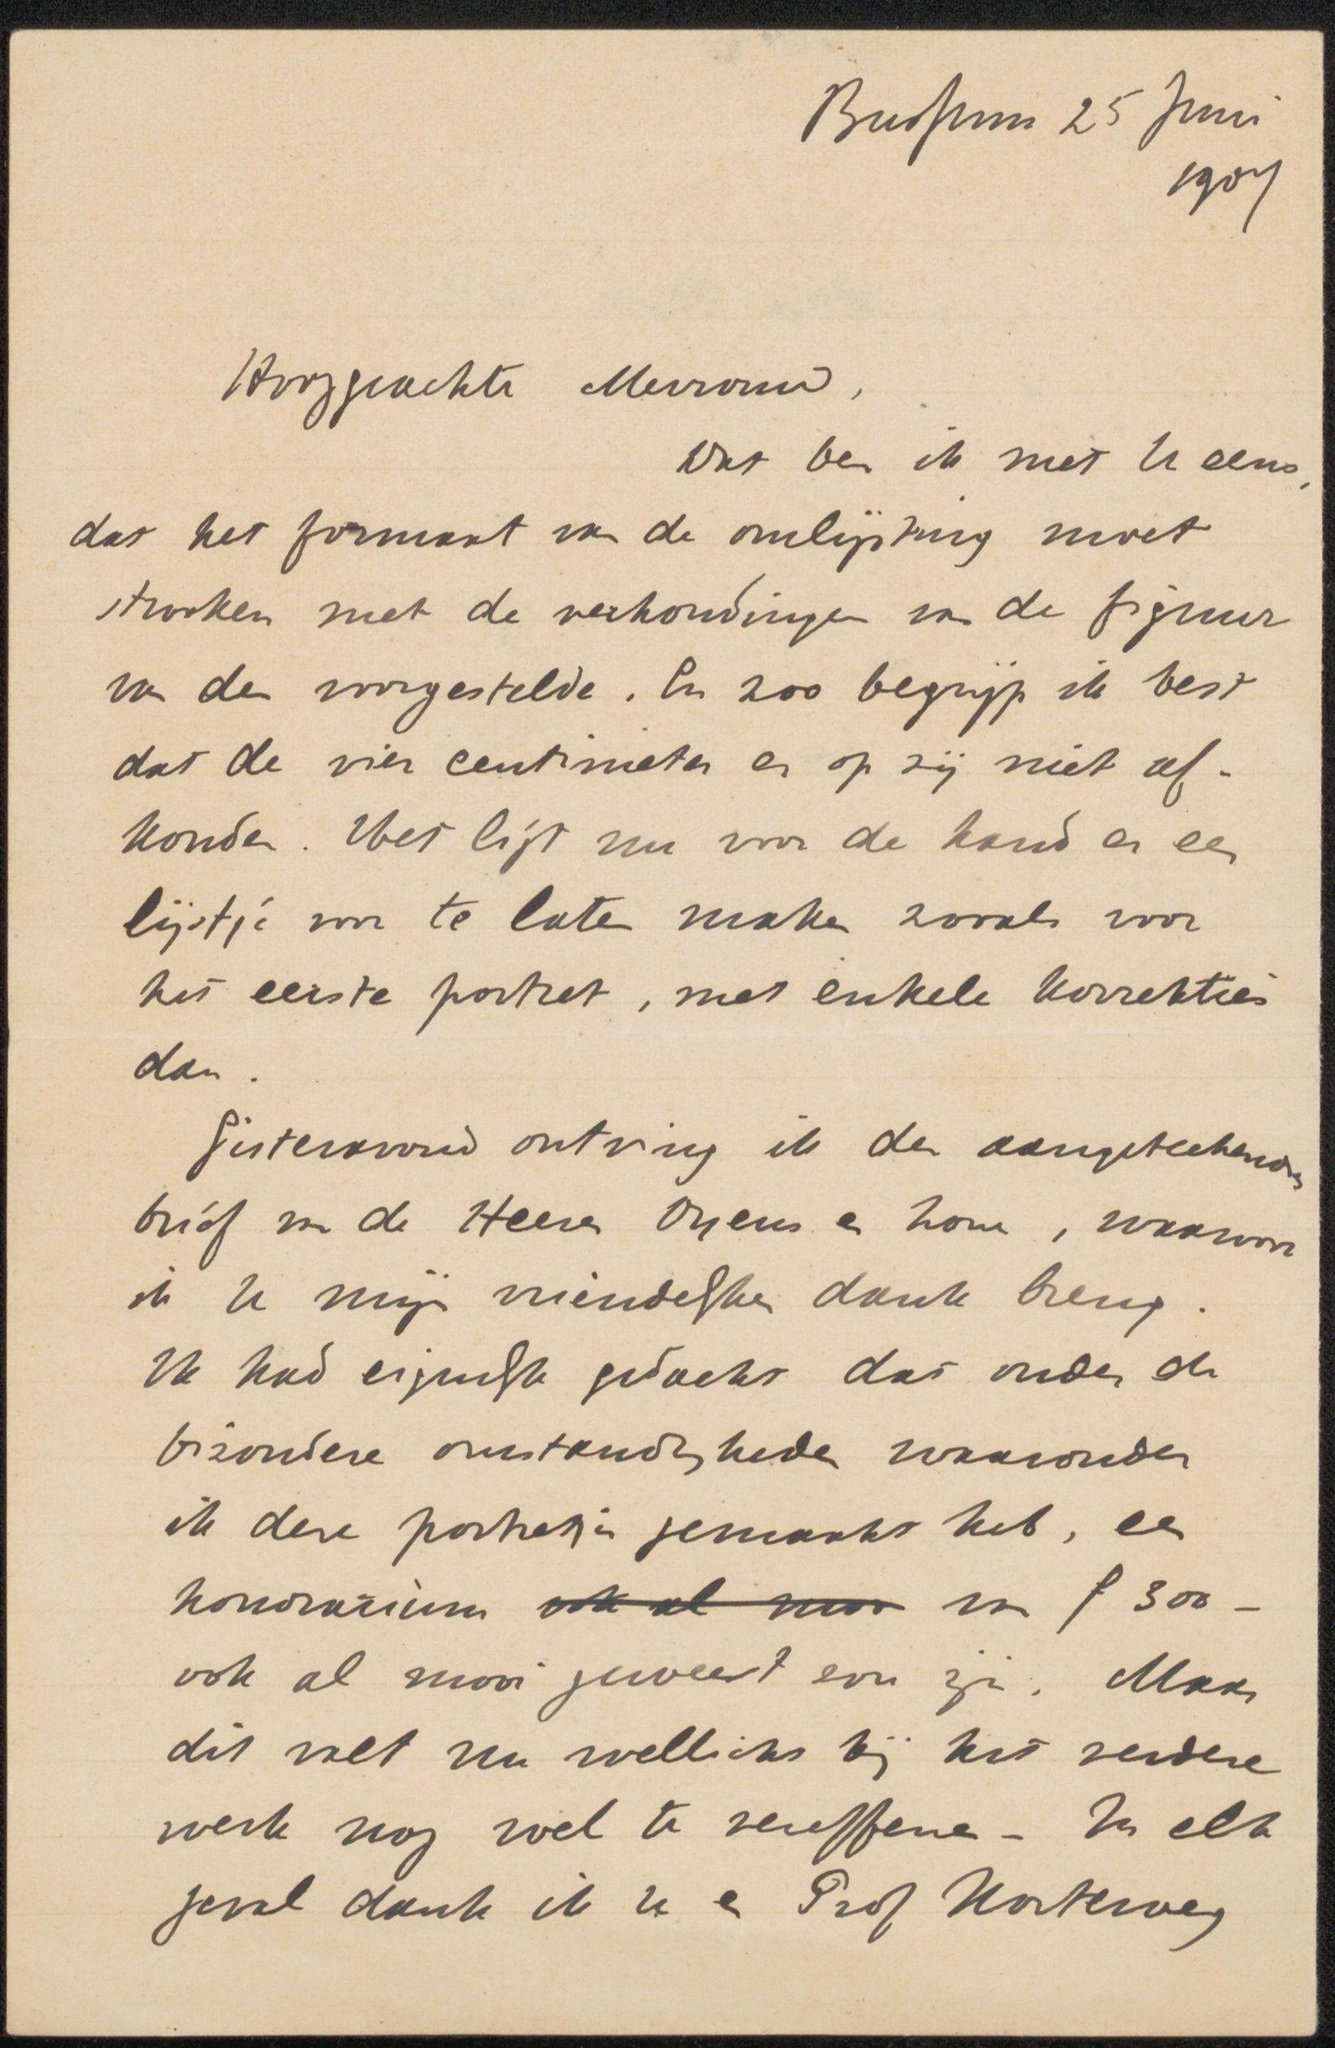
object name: letter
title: Brief aan Wibbina Maria Korteweg-d'Aulnis de Bourrouil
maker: jan veth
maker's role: designer, draughtsman, painter, print maker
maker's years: 1864-1925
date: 1907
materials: ink, paper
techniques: pen, writing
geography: bussum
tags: pieter oyens, brussels, david oyens, wibbina maria barones korteweg-d'aulnis de bourrouil, den bosch, amsterdam, historical persons (portraits and scenes from the life), money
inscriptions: collector's mark: ‘RPK’